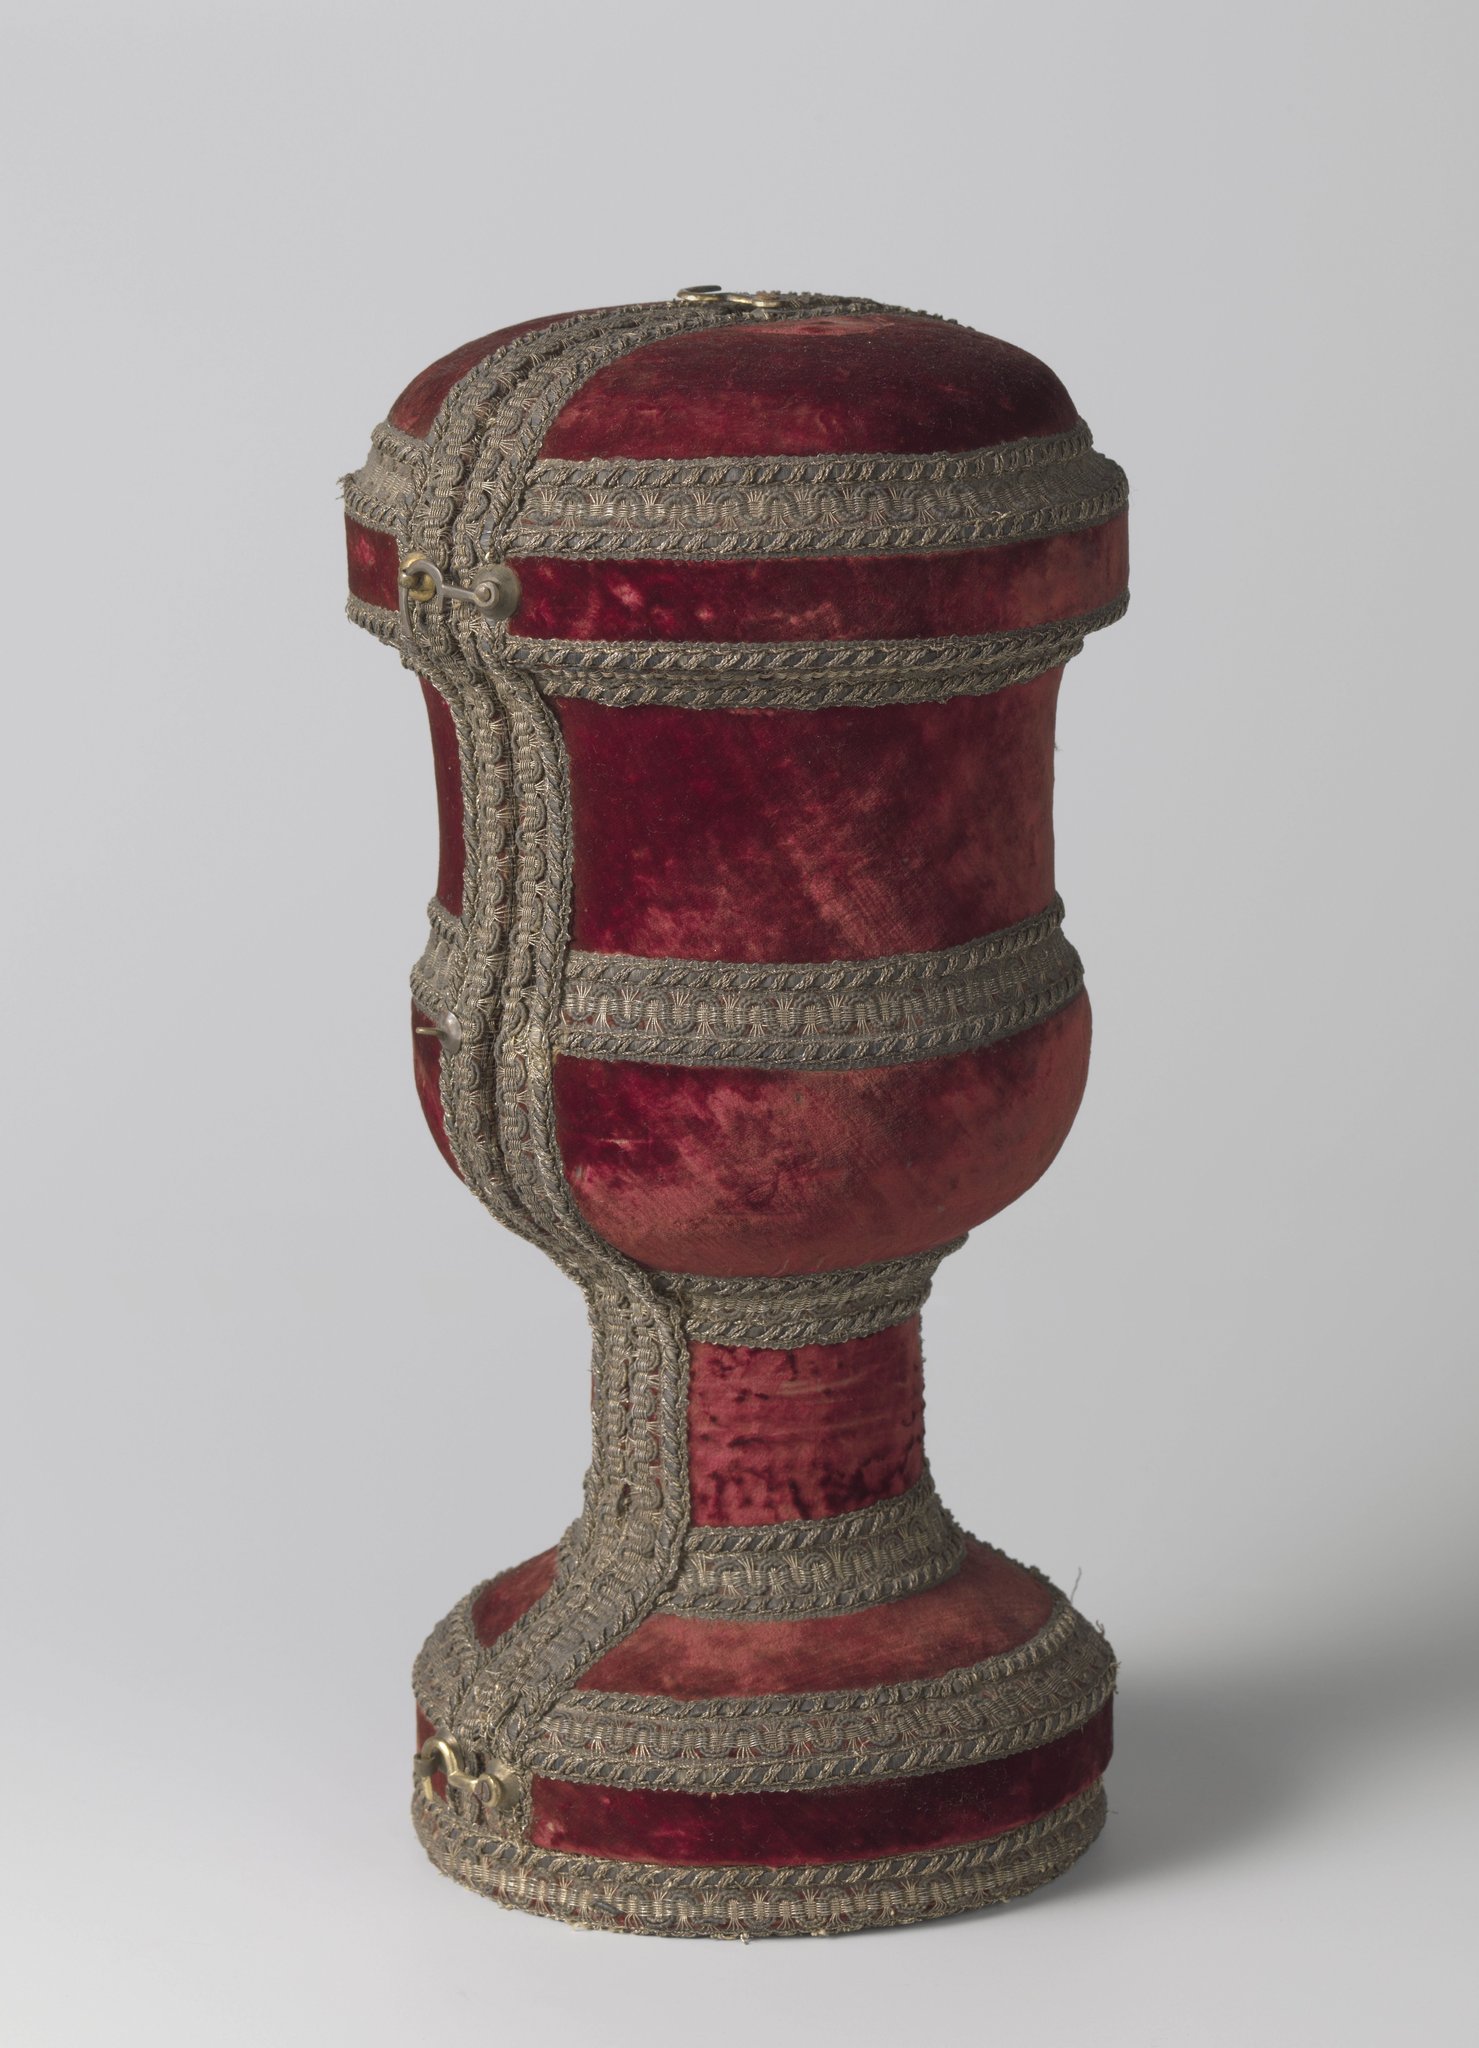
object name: case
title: Foedraal bij beker van Michiel Adriaenszoon de Ruyter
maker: Anonymous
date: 1667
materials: velvet, wood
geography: the hague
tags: flushing, michiel adriaenszoon de ruyter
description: Houten foedraal met rood fluweel overtrokken en met zilvergalon versierd.